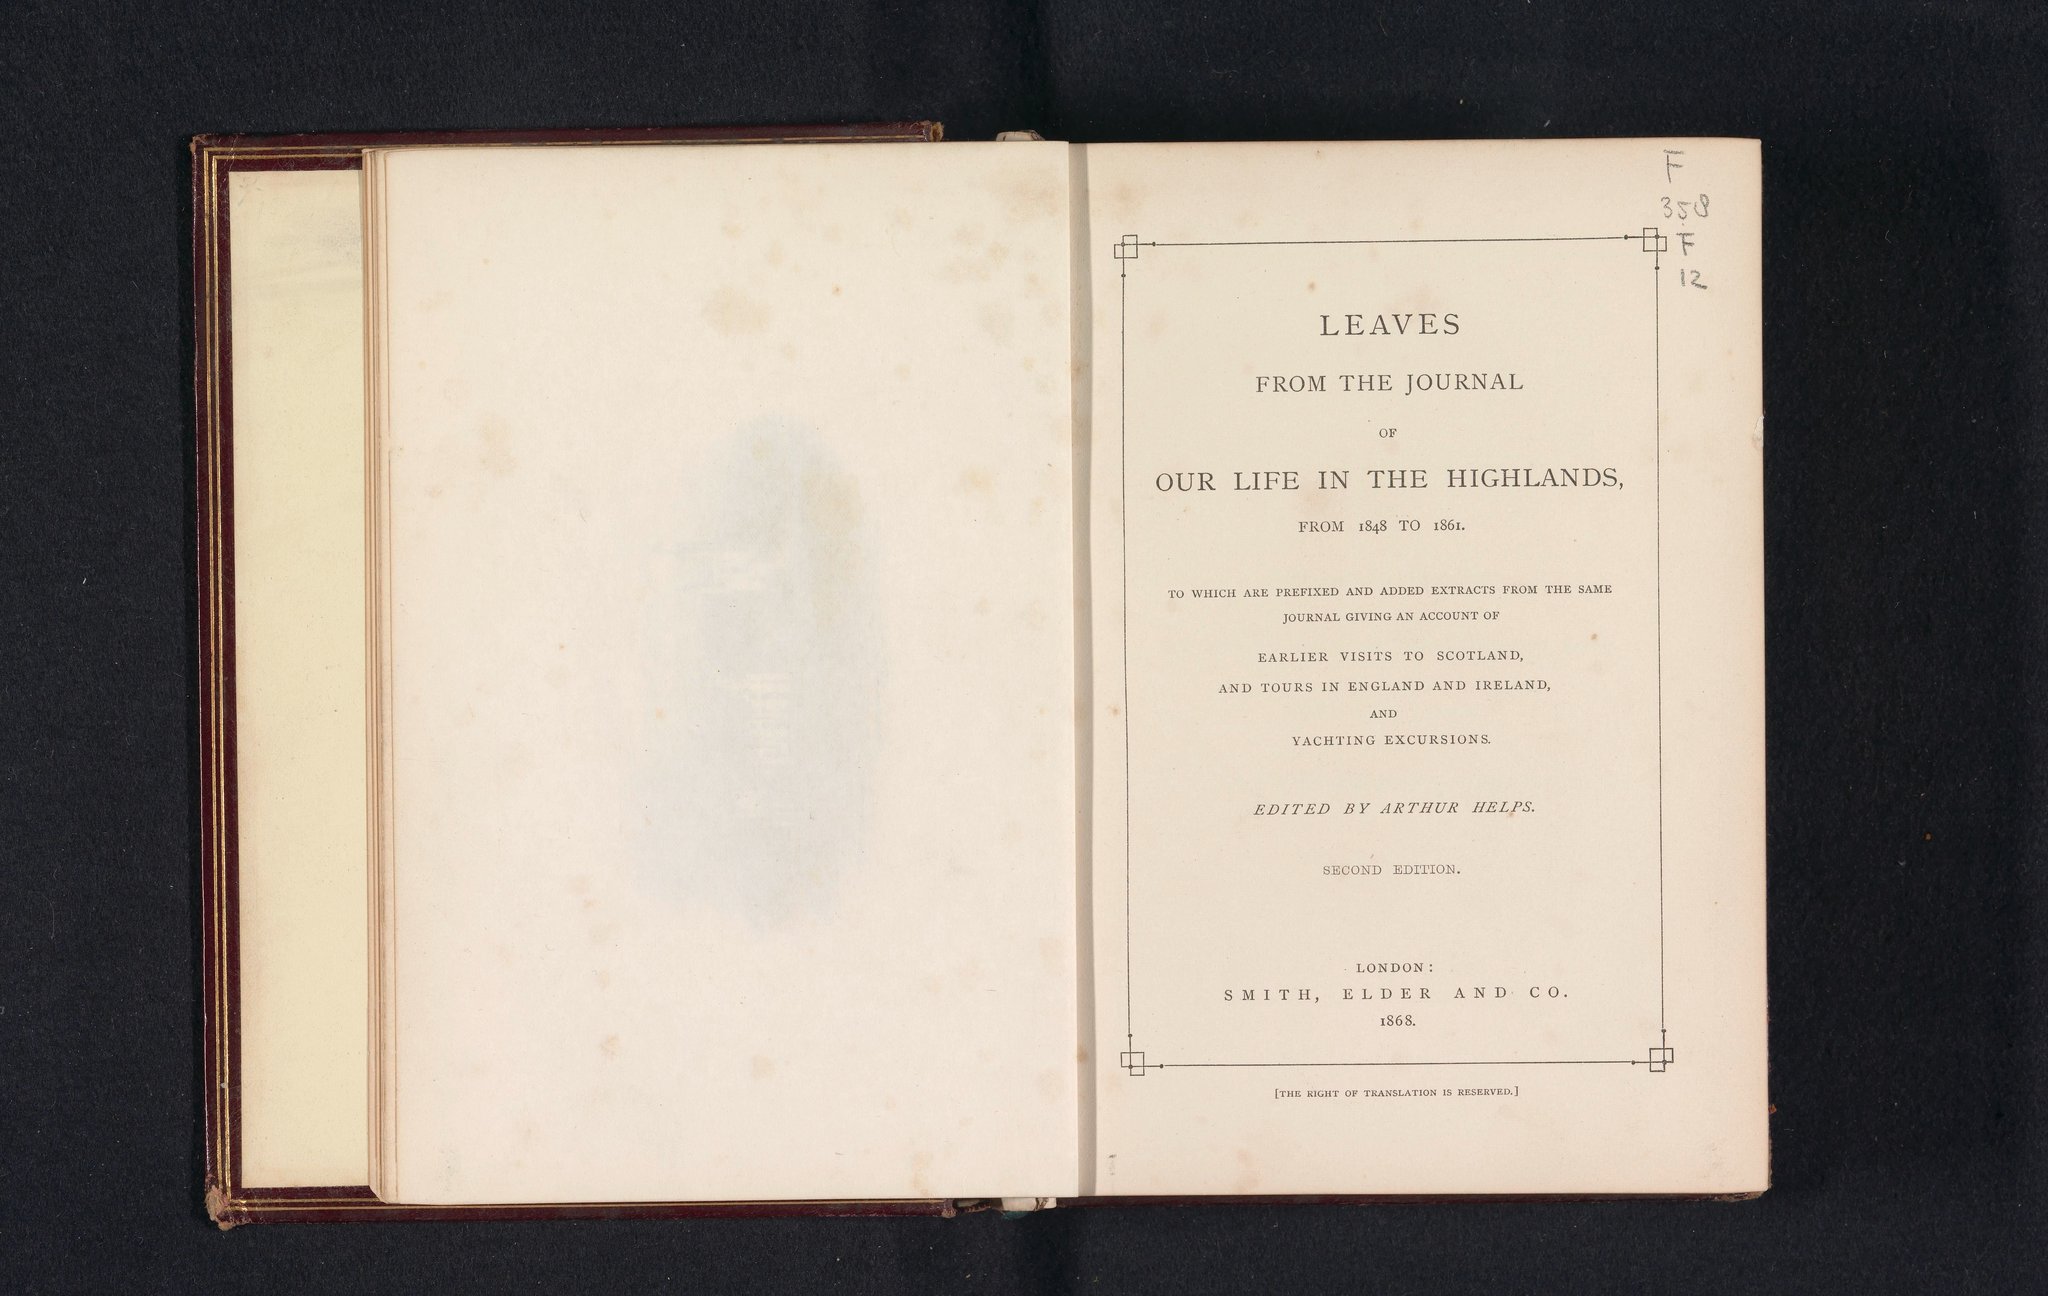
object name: book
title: Leaves from the journal of our life in the Highlands from 1848 to 1861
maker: arthur helps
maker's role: schrijver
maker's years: 1813-1875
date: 1868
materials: cardboard, leather, paper, photographic support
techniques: albumen print, printing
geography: london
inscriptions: inscription: ‘Clar[...] 1868’, bookplate: ‘Altins ibunt nituntur qui ad summa Daniel Sharpe’